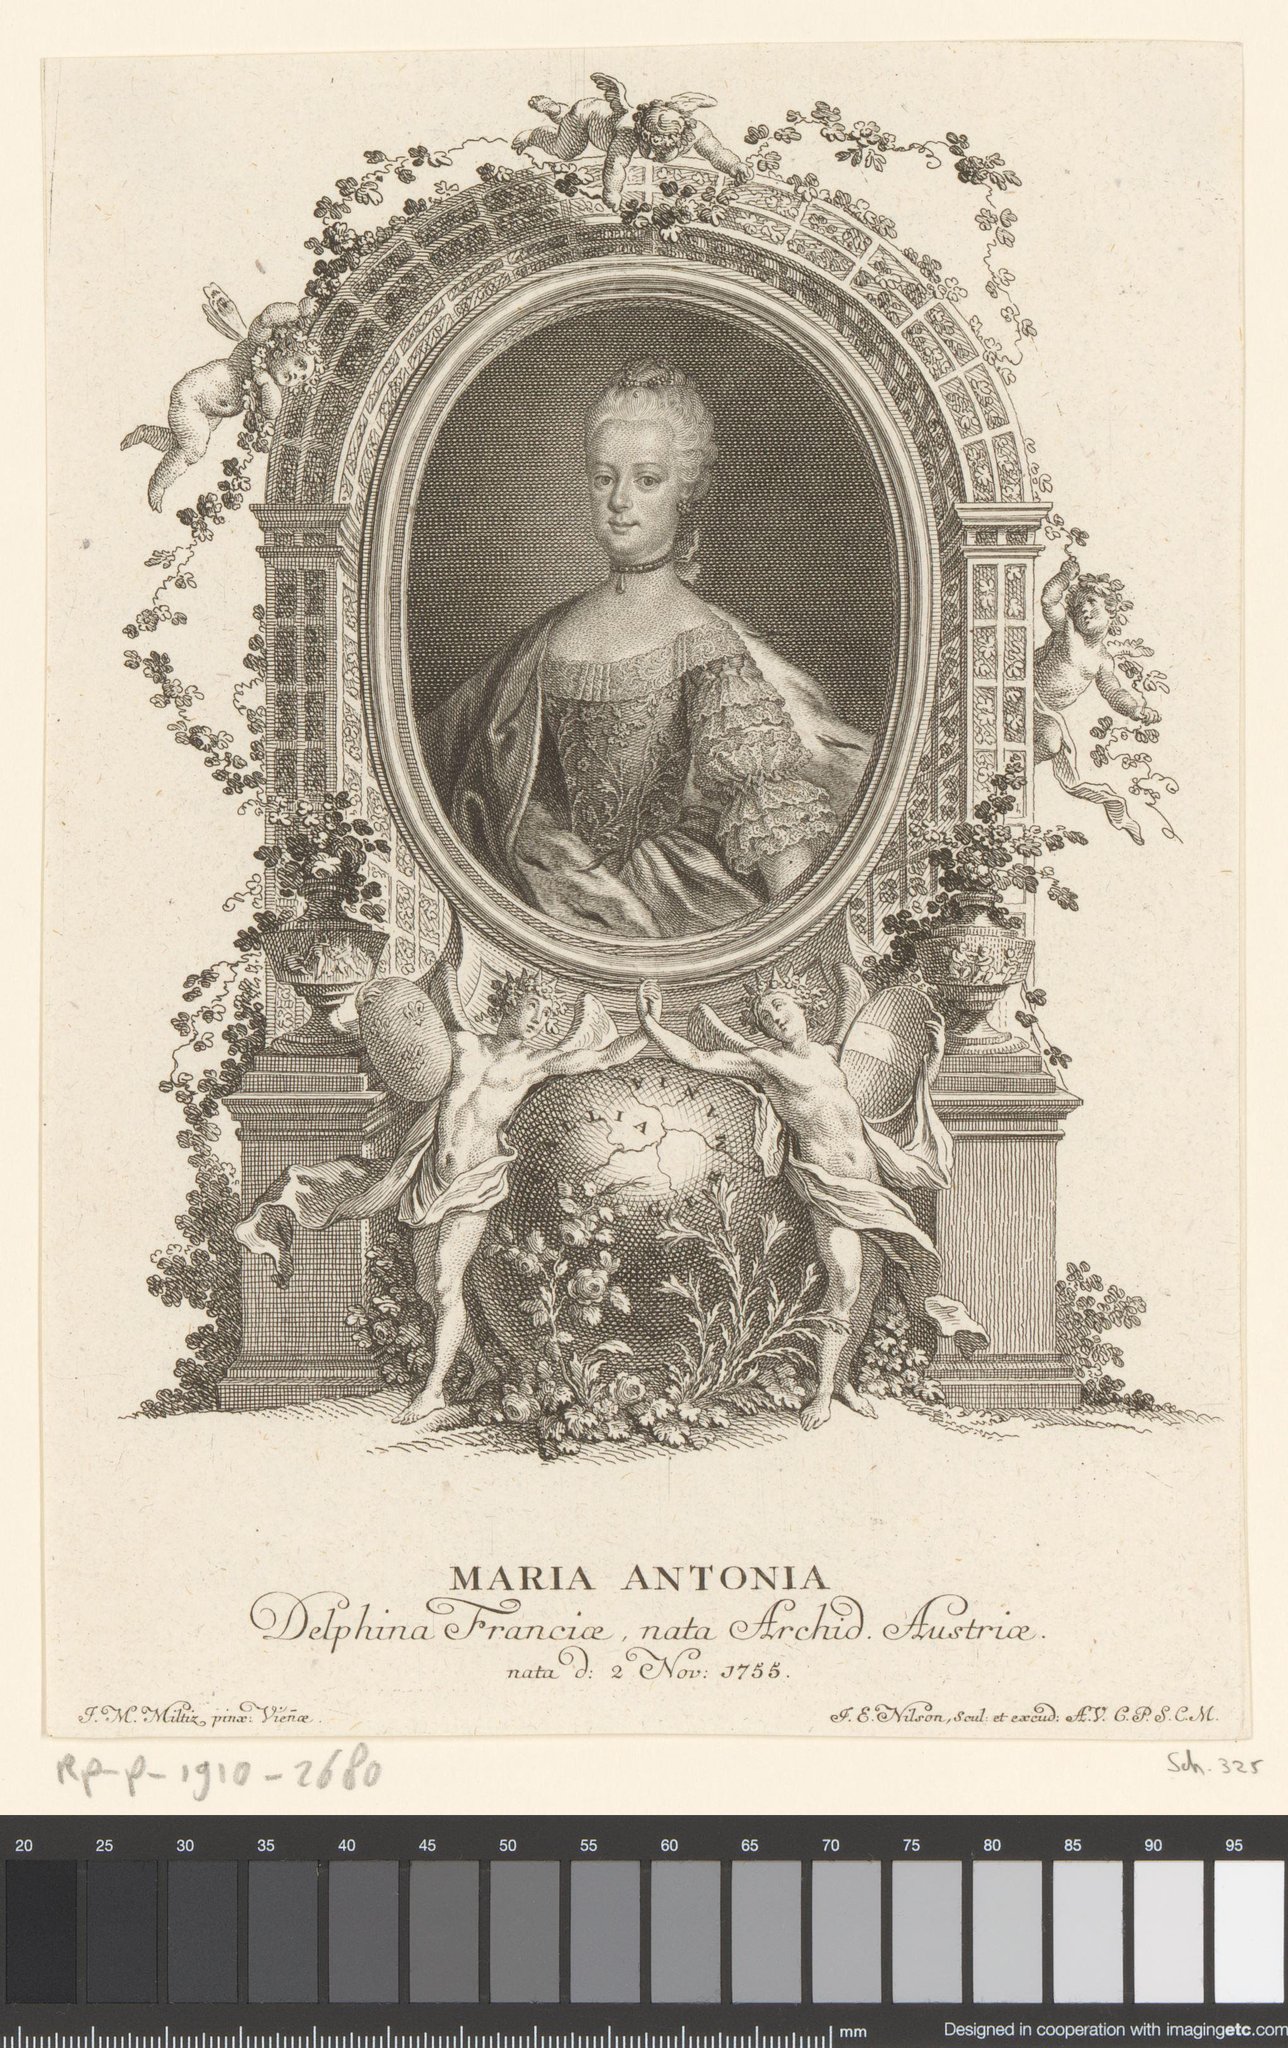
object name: print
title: Portret van Marie-Antoinette van Oostenrijk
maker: johann esaias nilson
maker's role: draughtsman, print maker, publisher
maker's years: 1721-1788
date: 1770-1788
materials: paper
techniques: engraving, etching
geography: augsburg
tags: vienna, paris, marie antoinette, historical persons, globe, baton of general, peace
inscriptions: collector's mark: Lugt 2228